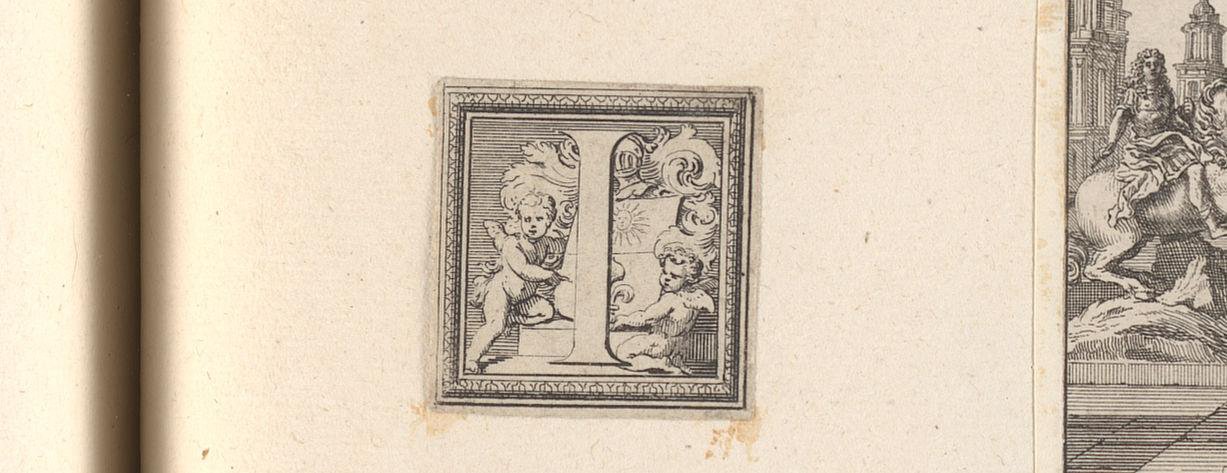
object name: print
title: Initiaal 'I' met twee putti bij het wapen van Lebrun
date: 1683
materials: paper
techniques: etching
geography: paris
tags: initial, cupids: 'amores', 'amoretti', 'putti', armorial bearing, heraldry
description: Prent uit: Mignard, Paul. Ode à Mr Lebrun premier peintre du Roy. Parijs: Pierre Le Petit, 1683.